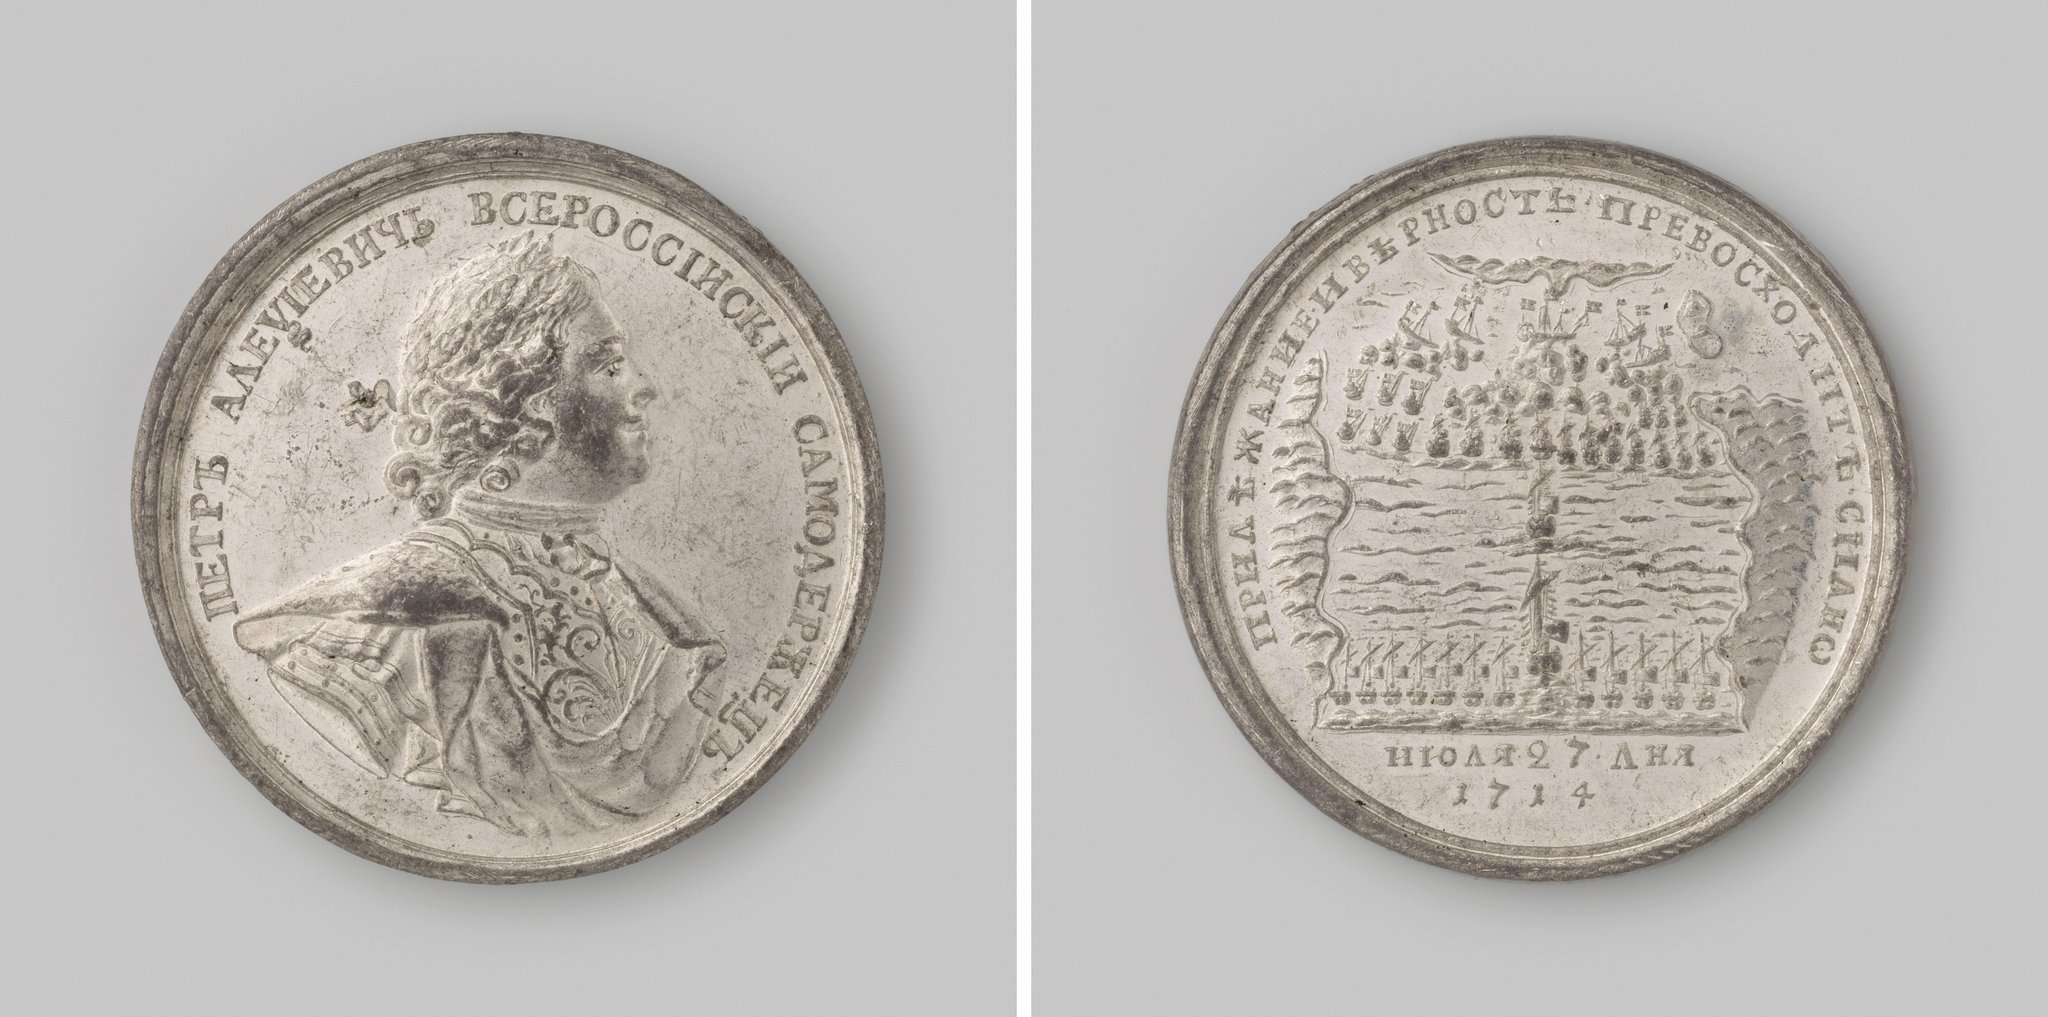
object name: history medal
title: Overwinning van Rusland op Zweden in de Zeeslag bij Aland 1714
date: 1714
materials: tin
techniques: striking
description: Tinnen penning, op de voorzijde het borstbeeld van Tsaar Peter de Grote naar rechts met omschrift, op de keerzijde het aanzicht van de zeeslag in vogelvlucht, met omschrift en afsnedetekst.